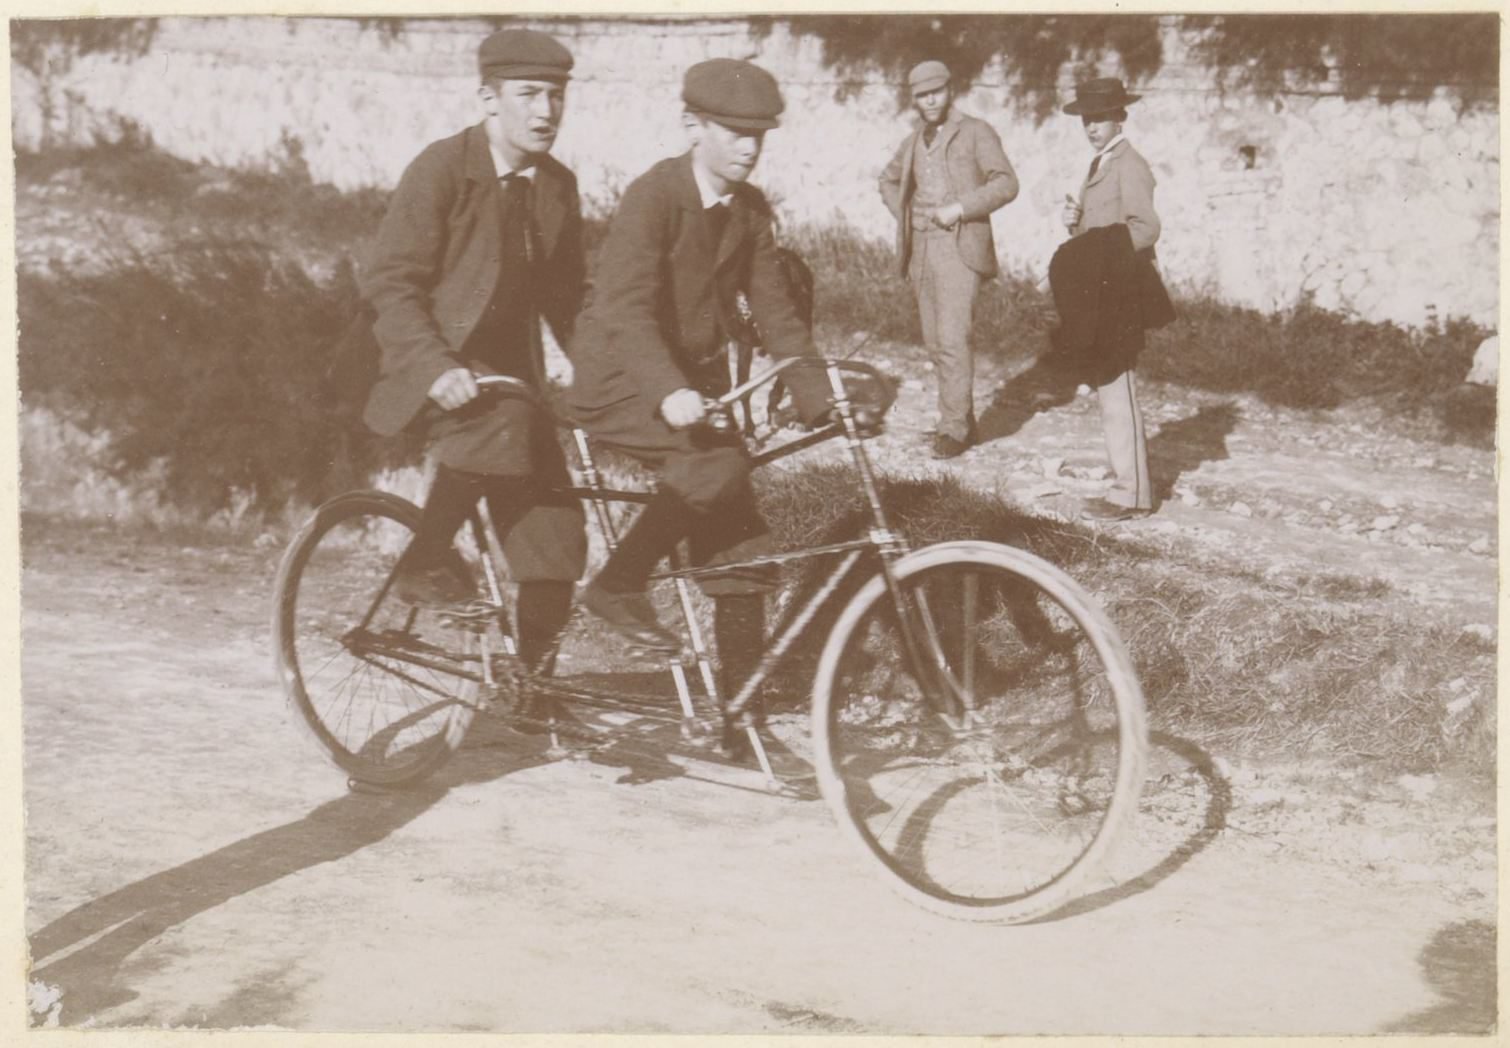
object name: photograph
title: Twee Franse jongens op een tandem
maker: Anonymous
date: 1900-1910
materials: paper, photographic support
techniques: daylight paper print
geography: france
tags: riding, cycling (recreation), tandem, france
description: Onderdeel van Fotoalbum van een Franse amateurfotograaf met opnames van een familie, distilleerderij Delizy & Doistau Fils, het leger en bezienswaardigheden in Frankrijk.